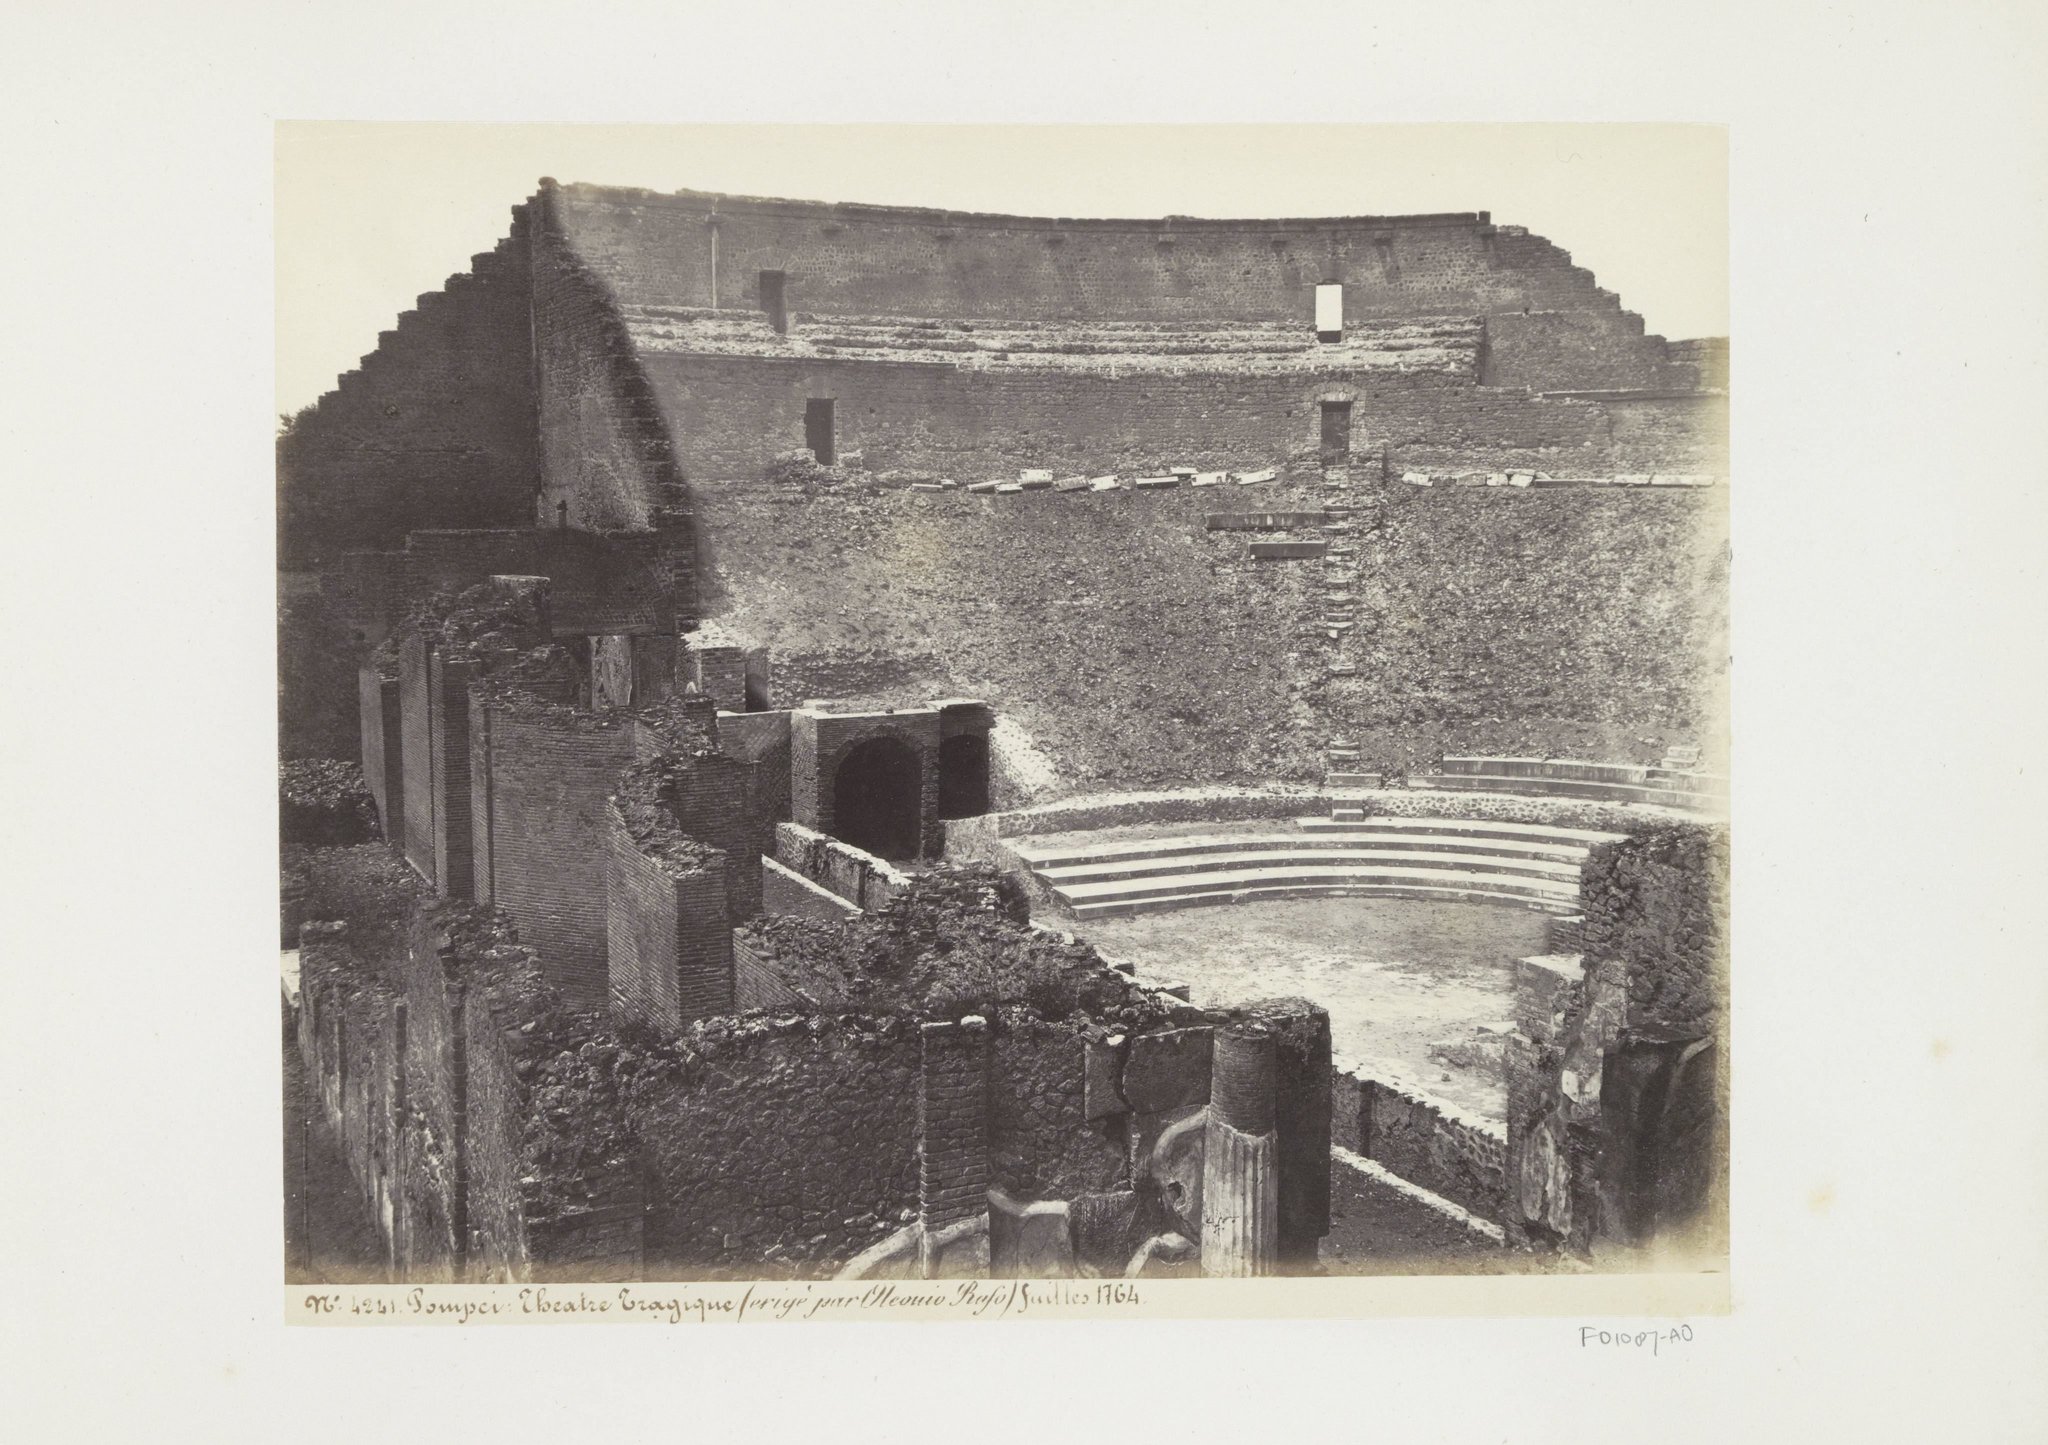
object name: photograph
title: Restanten van het theater van Pompeï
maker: Anonymous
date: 1865-1875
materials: paper, photographic support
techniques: albumen print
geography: pompeii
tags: theatre (building), excavation ~ archaeology, pompeii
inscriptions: negative number: ‘4241’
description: Onderdeel van Reisalbum met foto's van bezienswaardigheden in Napels en omgeving.